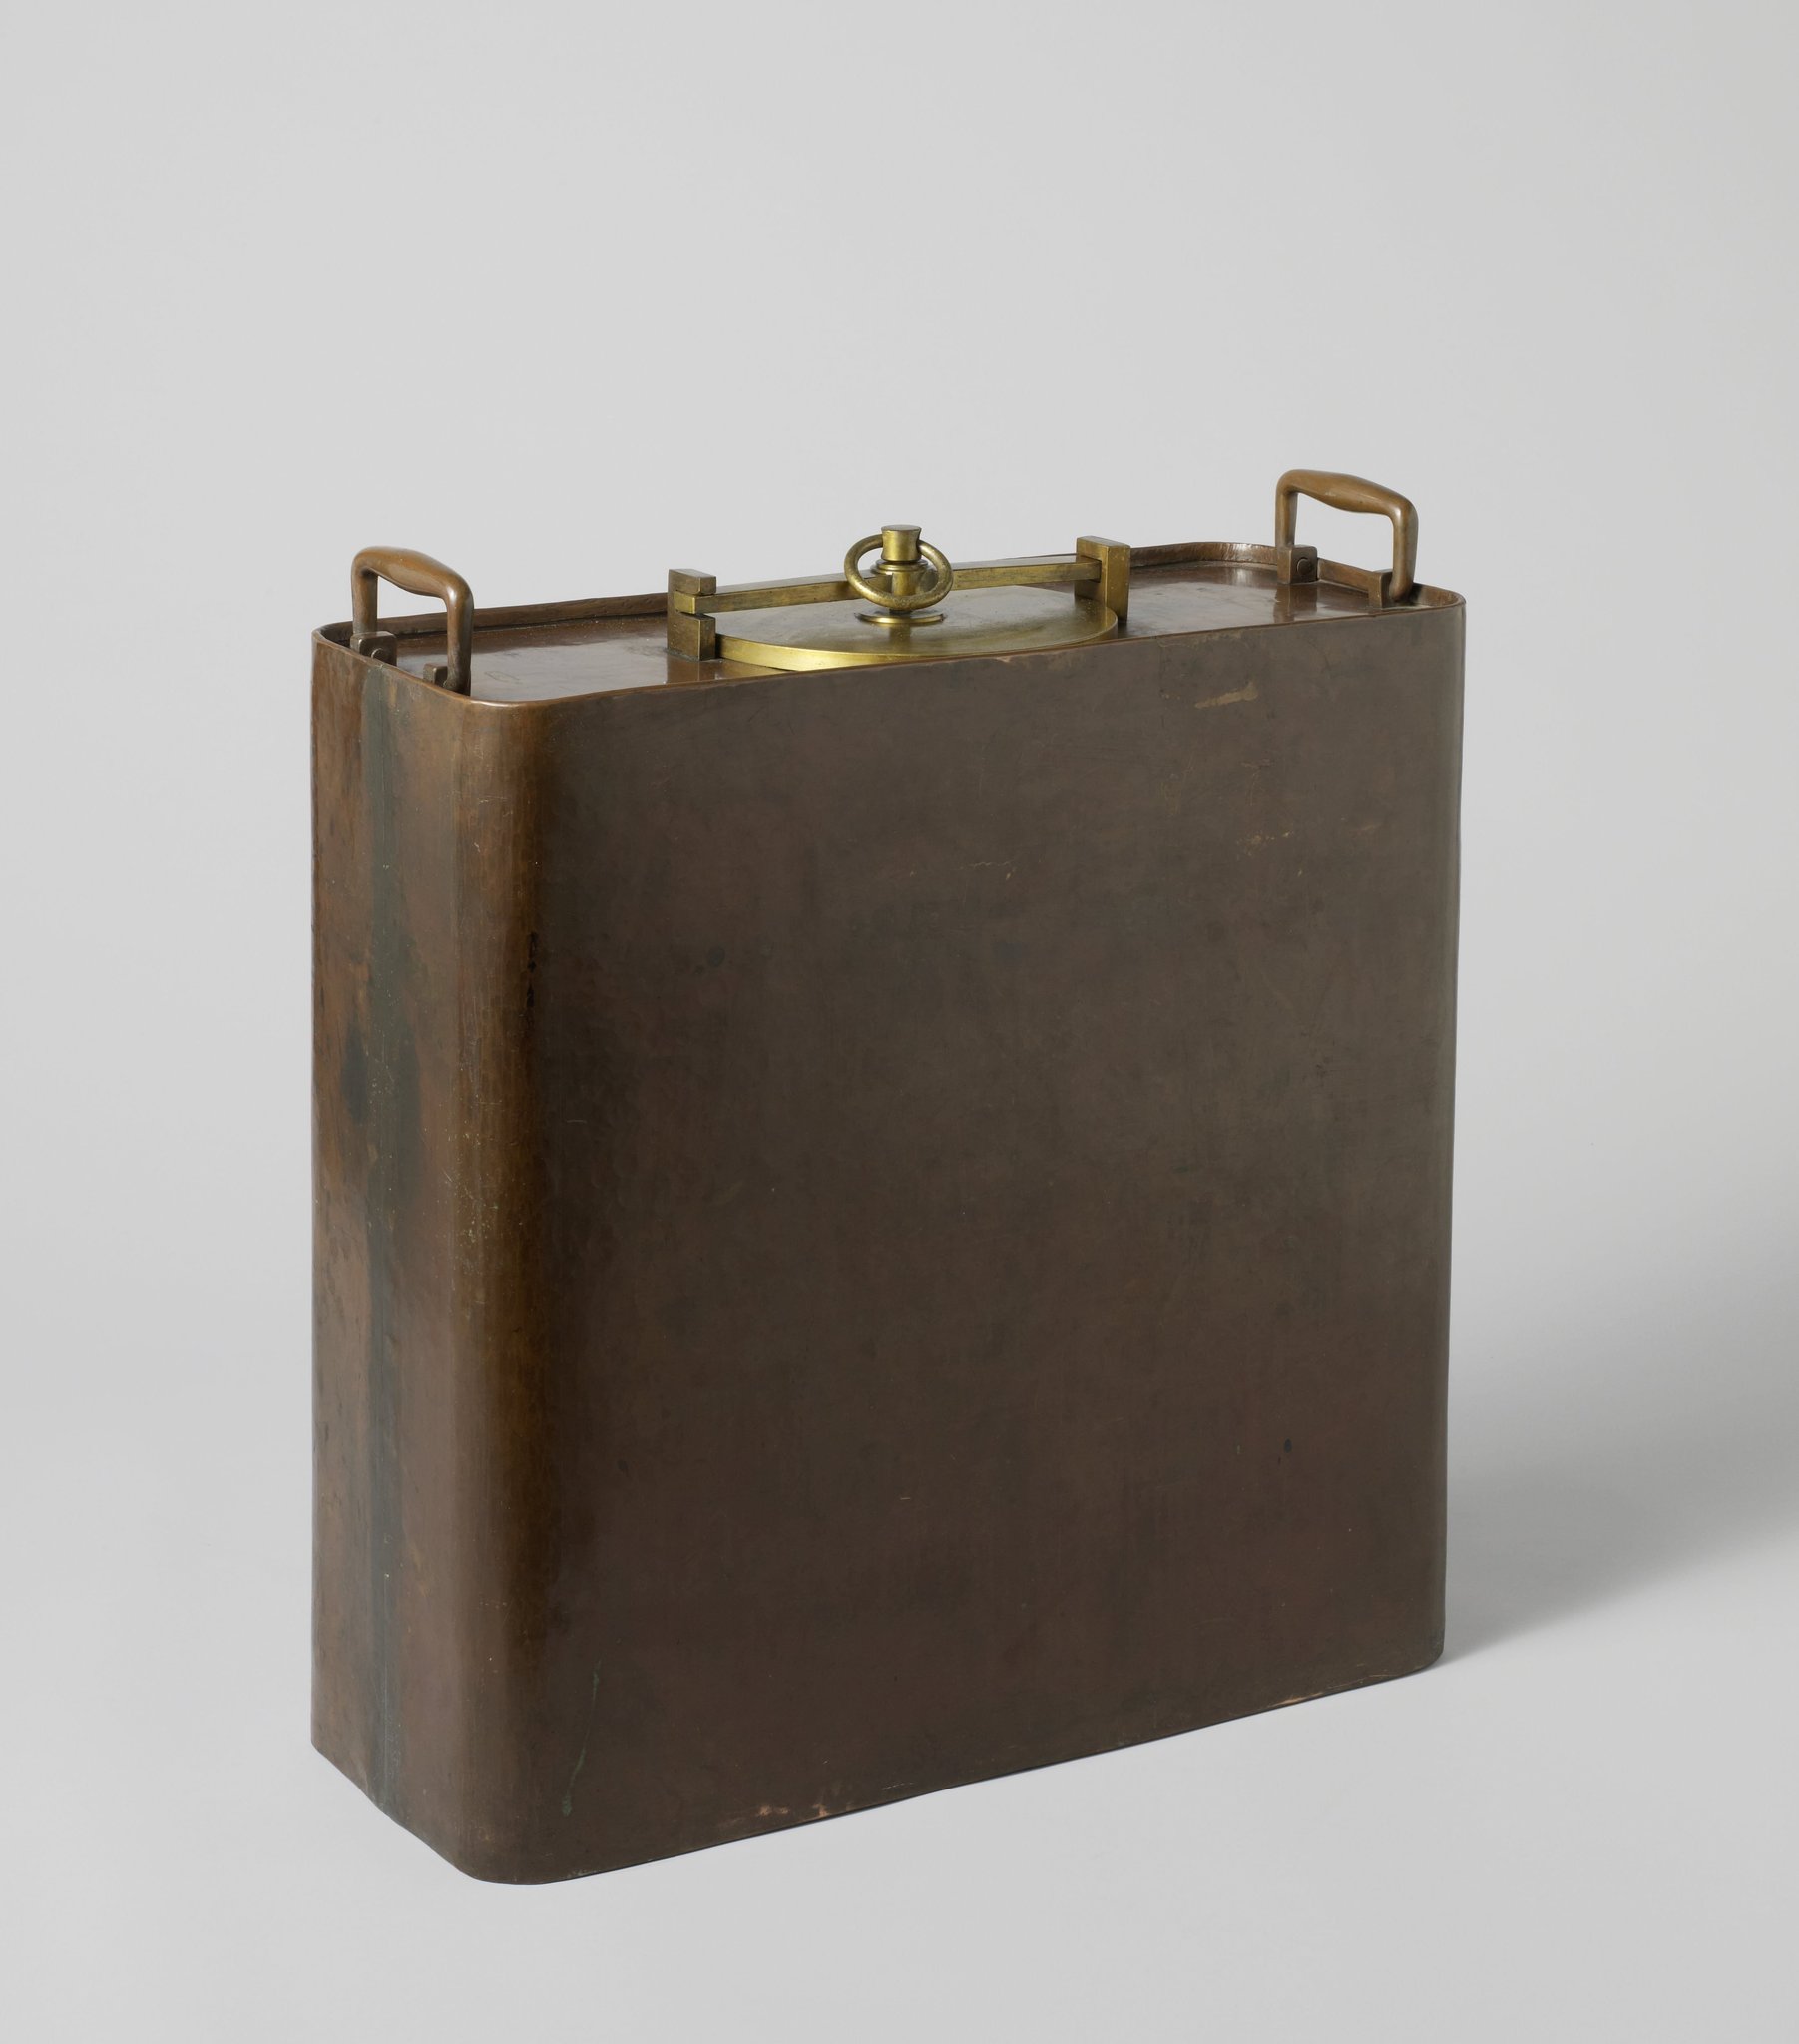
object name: chest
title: Powder Chest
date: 1866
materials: brass, copper, tin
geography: the hague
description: Rechthoekige koperen kruitkist met twee handvaten en een rond messing deksel. De binnenzijde is vertind. Het deksel is voorzien van een wervelsluiting, bestaande uit een messing staaf die draait om een bout in het midden van het deksel en zich onder twee nokken op de buitenrand van de opening vastklemt; met de bout wordt hij vervolgens aangedraaid.